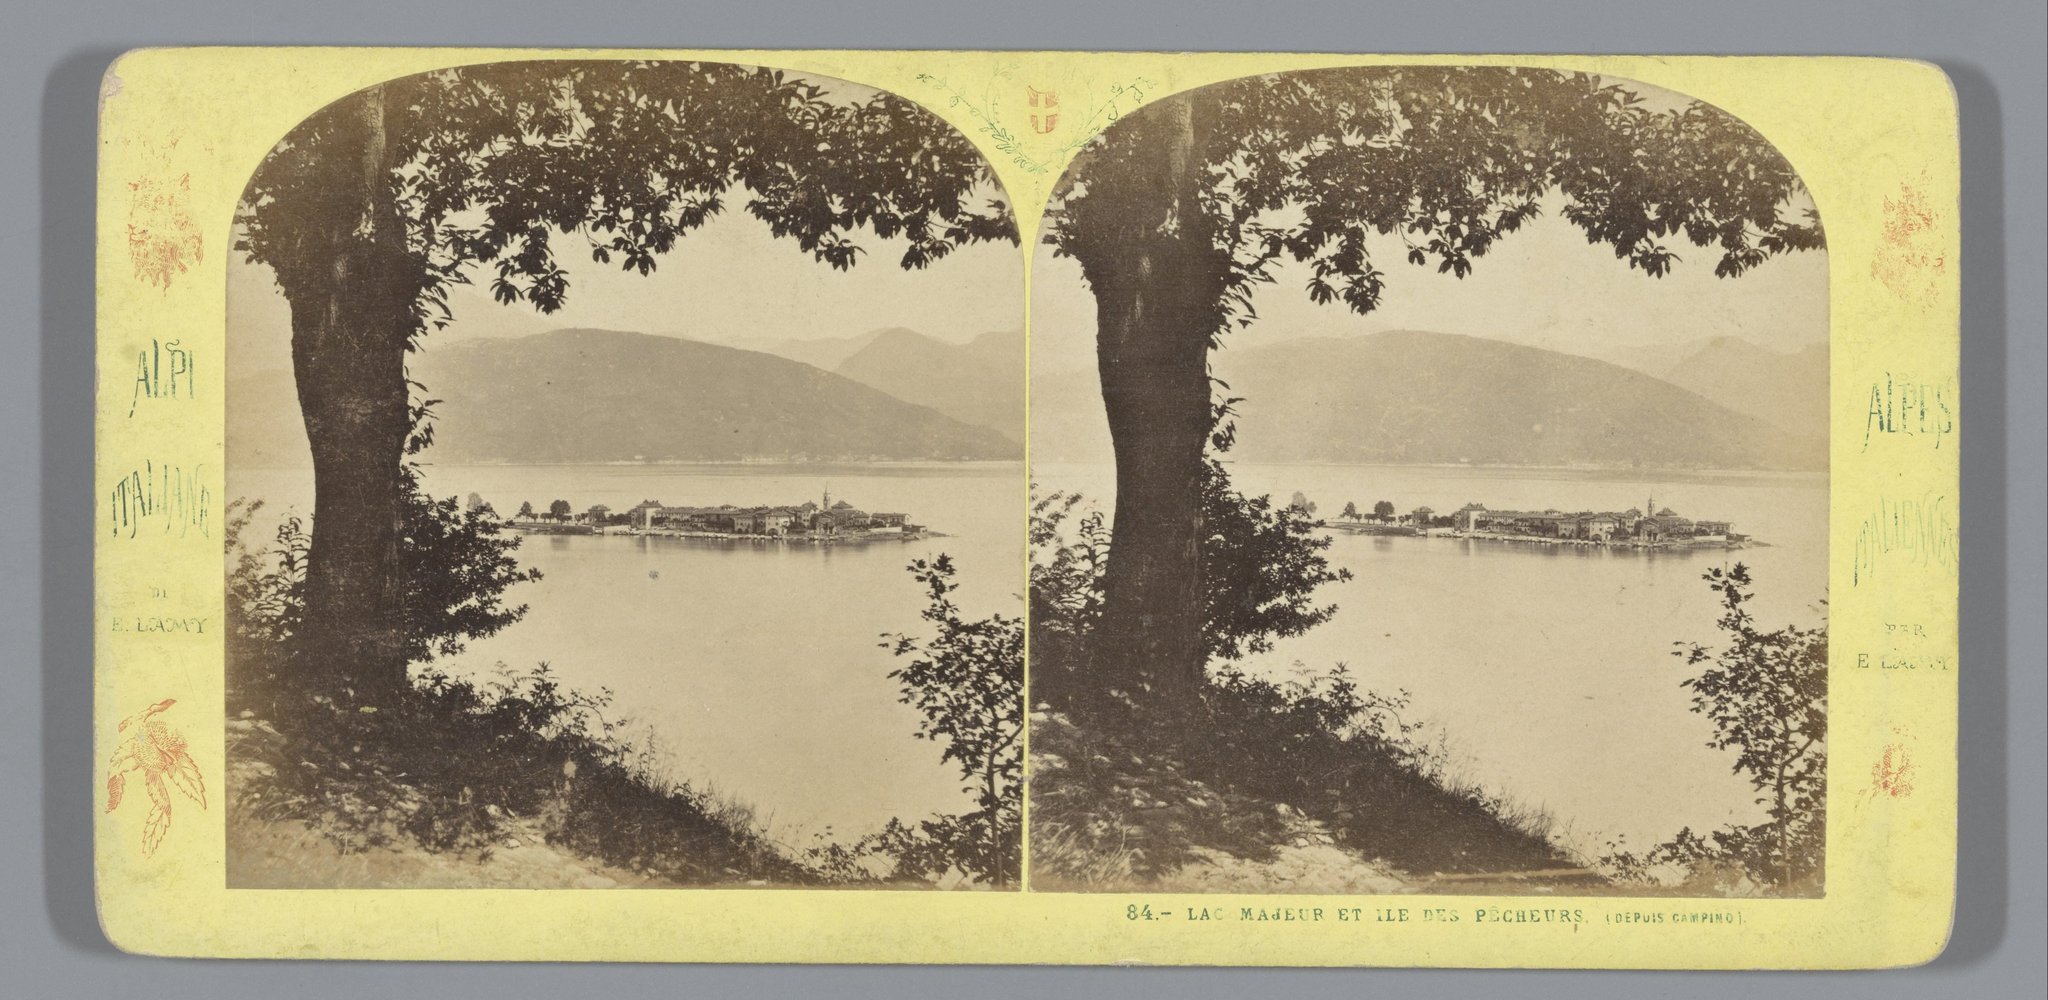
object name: stereograph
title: Alpi Italiane / Alpes Italiennes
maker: ernest eléonor pierre lamy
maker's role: publisher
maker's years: 1828-1900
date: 1861-1878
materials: cardboard, paper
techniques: albumen print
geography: isola dei pescatori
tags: island, lake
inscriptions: number: ‘84’